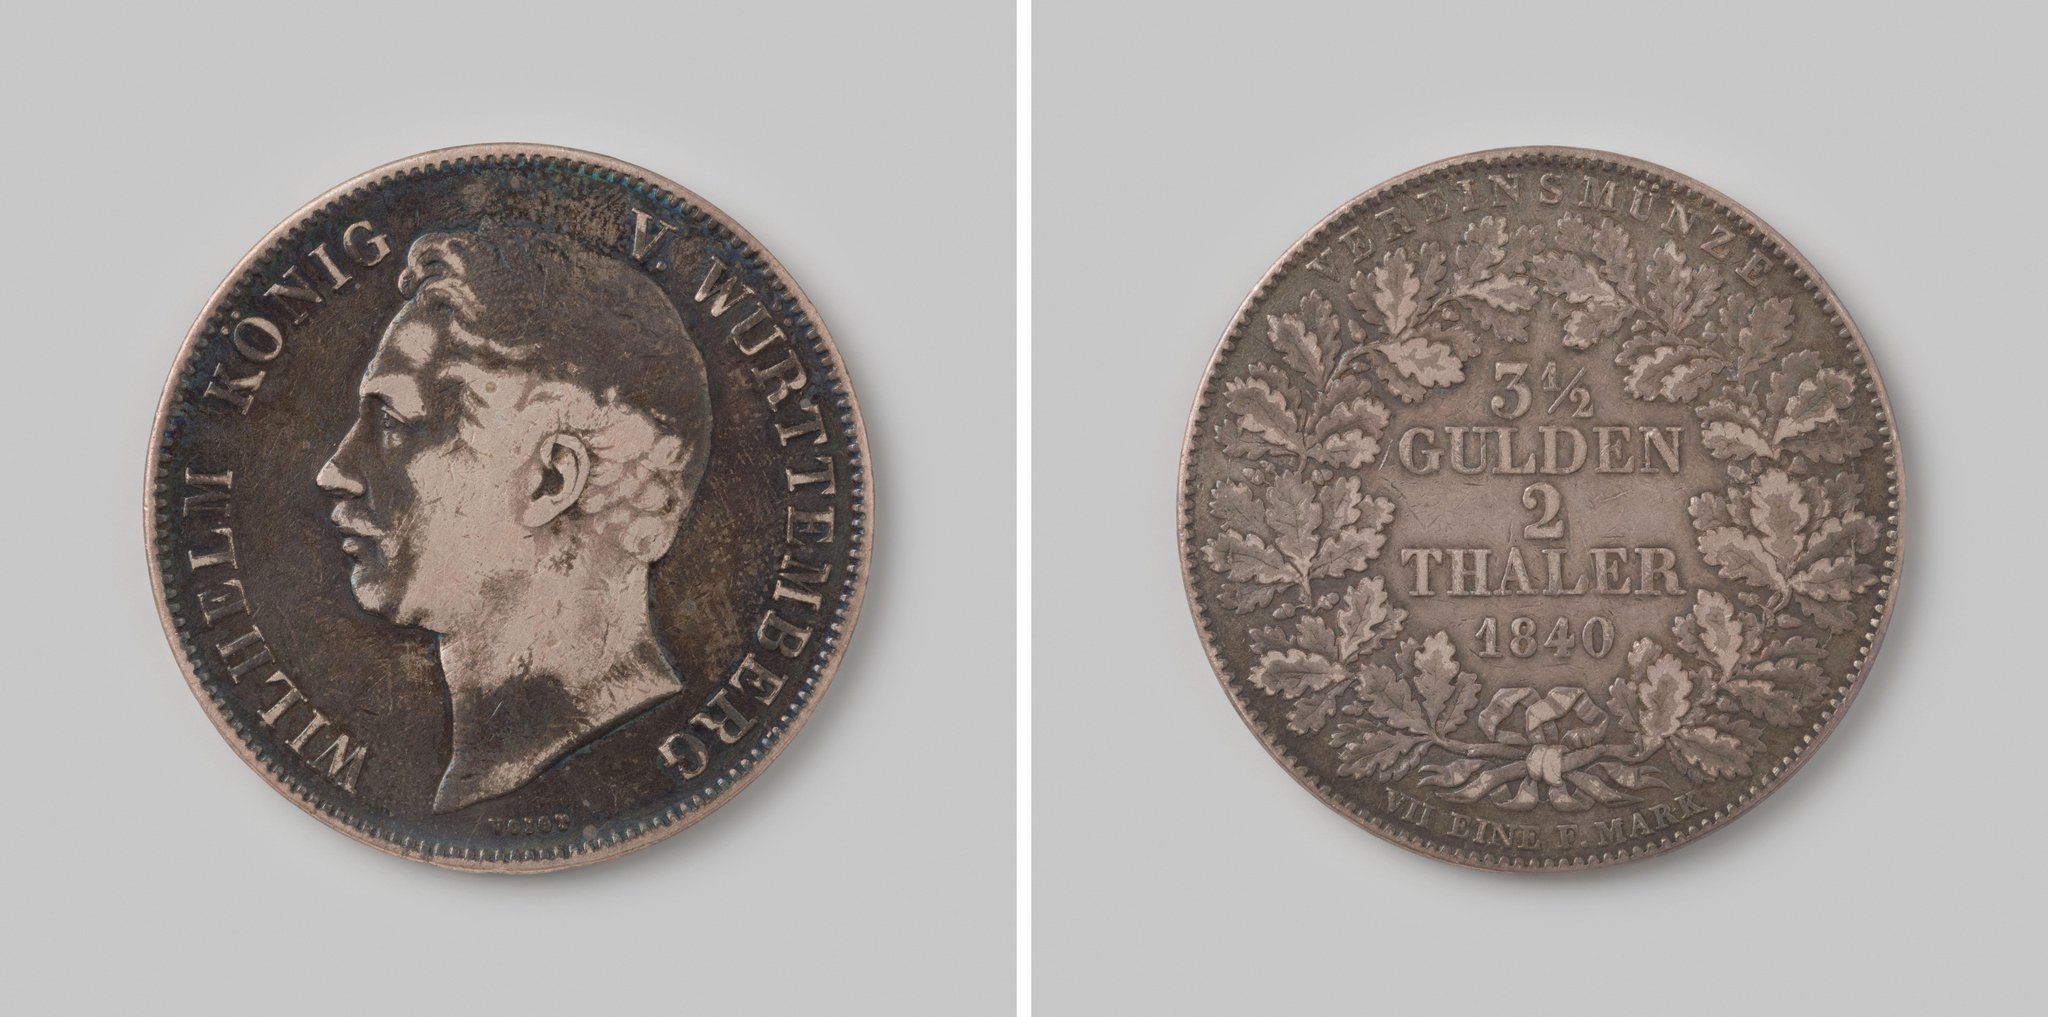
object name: dubbele taler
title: Dubbele taler uit het koninkrijk Wurtemberg van Wilhelm I, 1840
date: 1840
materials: silver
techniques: striking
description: Zilveren munt. Voorzijde: hoofd van de koning naar links. Keerzijde: binnen twee samengebonden eiketakken waarde-aanduidingen in vier regels, waaronder jaartal. Verwijzing naar muntconventie van 1838 in randschrift.